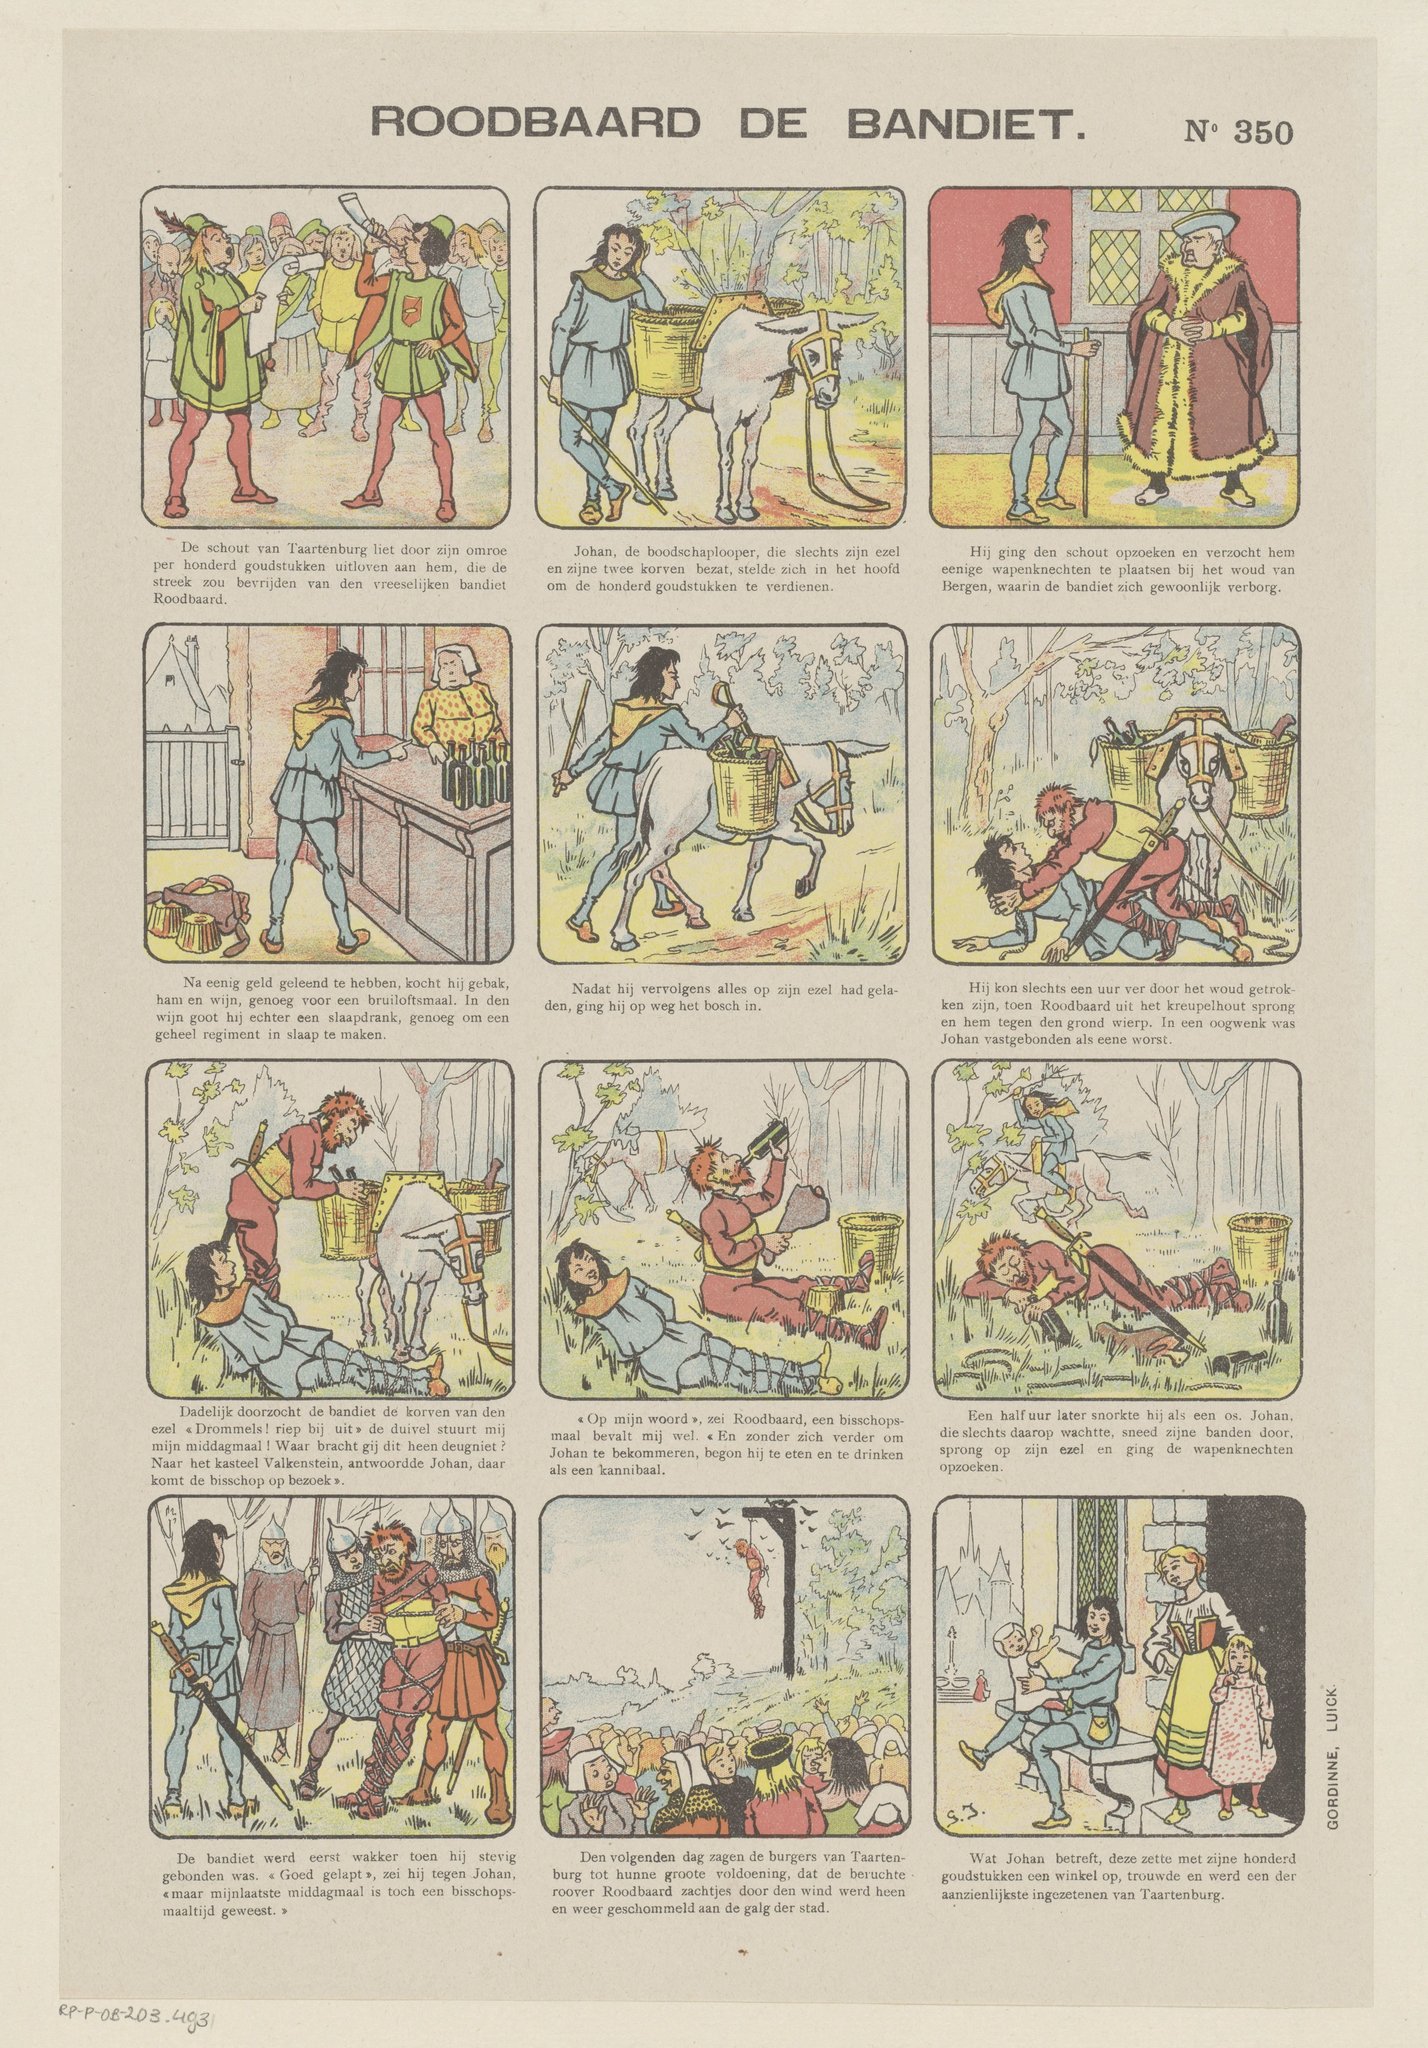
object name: print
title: Roodbaard de bandiet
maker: monogrammist g.j.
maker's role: print maker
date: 1894-1959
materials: paper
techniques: lithograph, letterpress printing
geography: liège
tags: violent death by hanging, theft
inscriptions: collector's mark: Lugt 2760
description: Blad met 12 voorstellingen over Johan de boodschaploper die Roodbaard de bandiet weet te vangen met een list. Onder elke afbeelding een onderschrift. Genummerd rechtsboven: No 350.